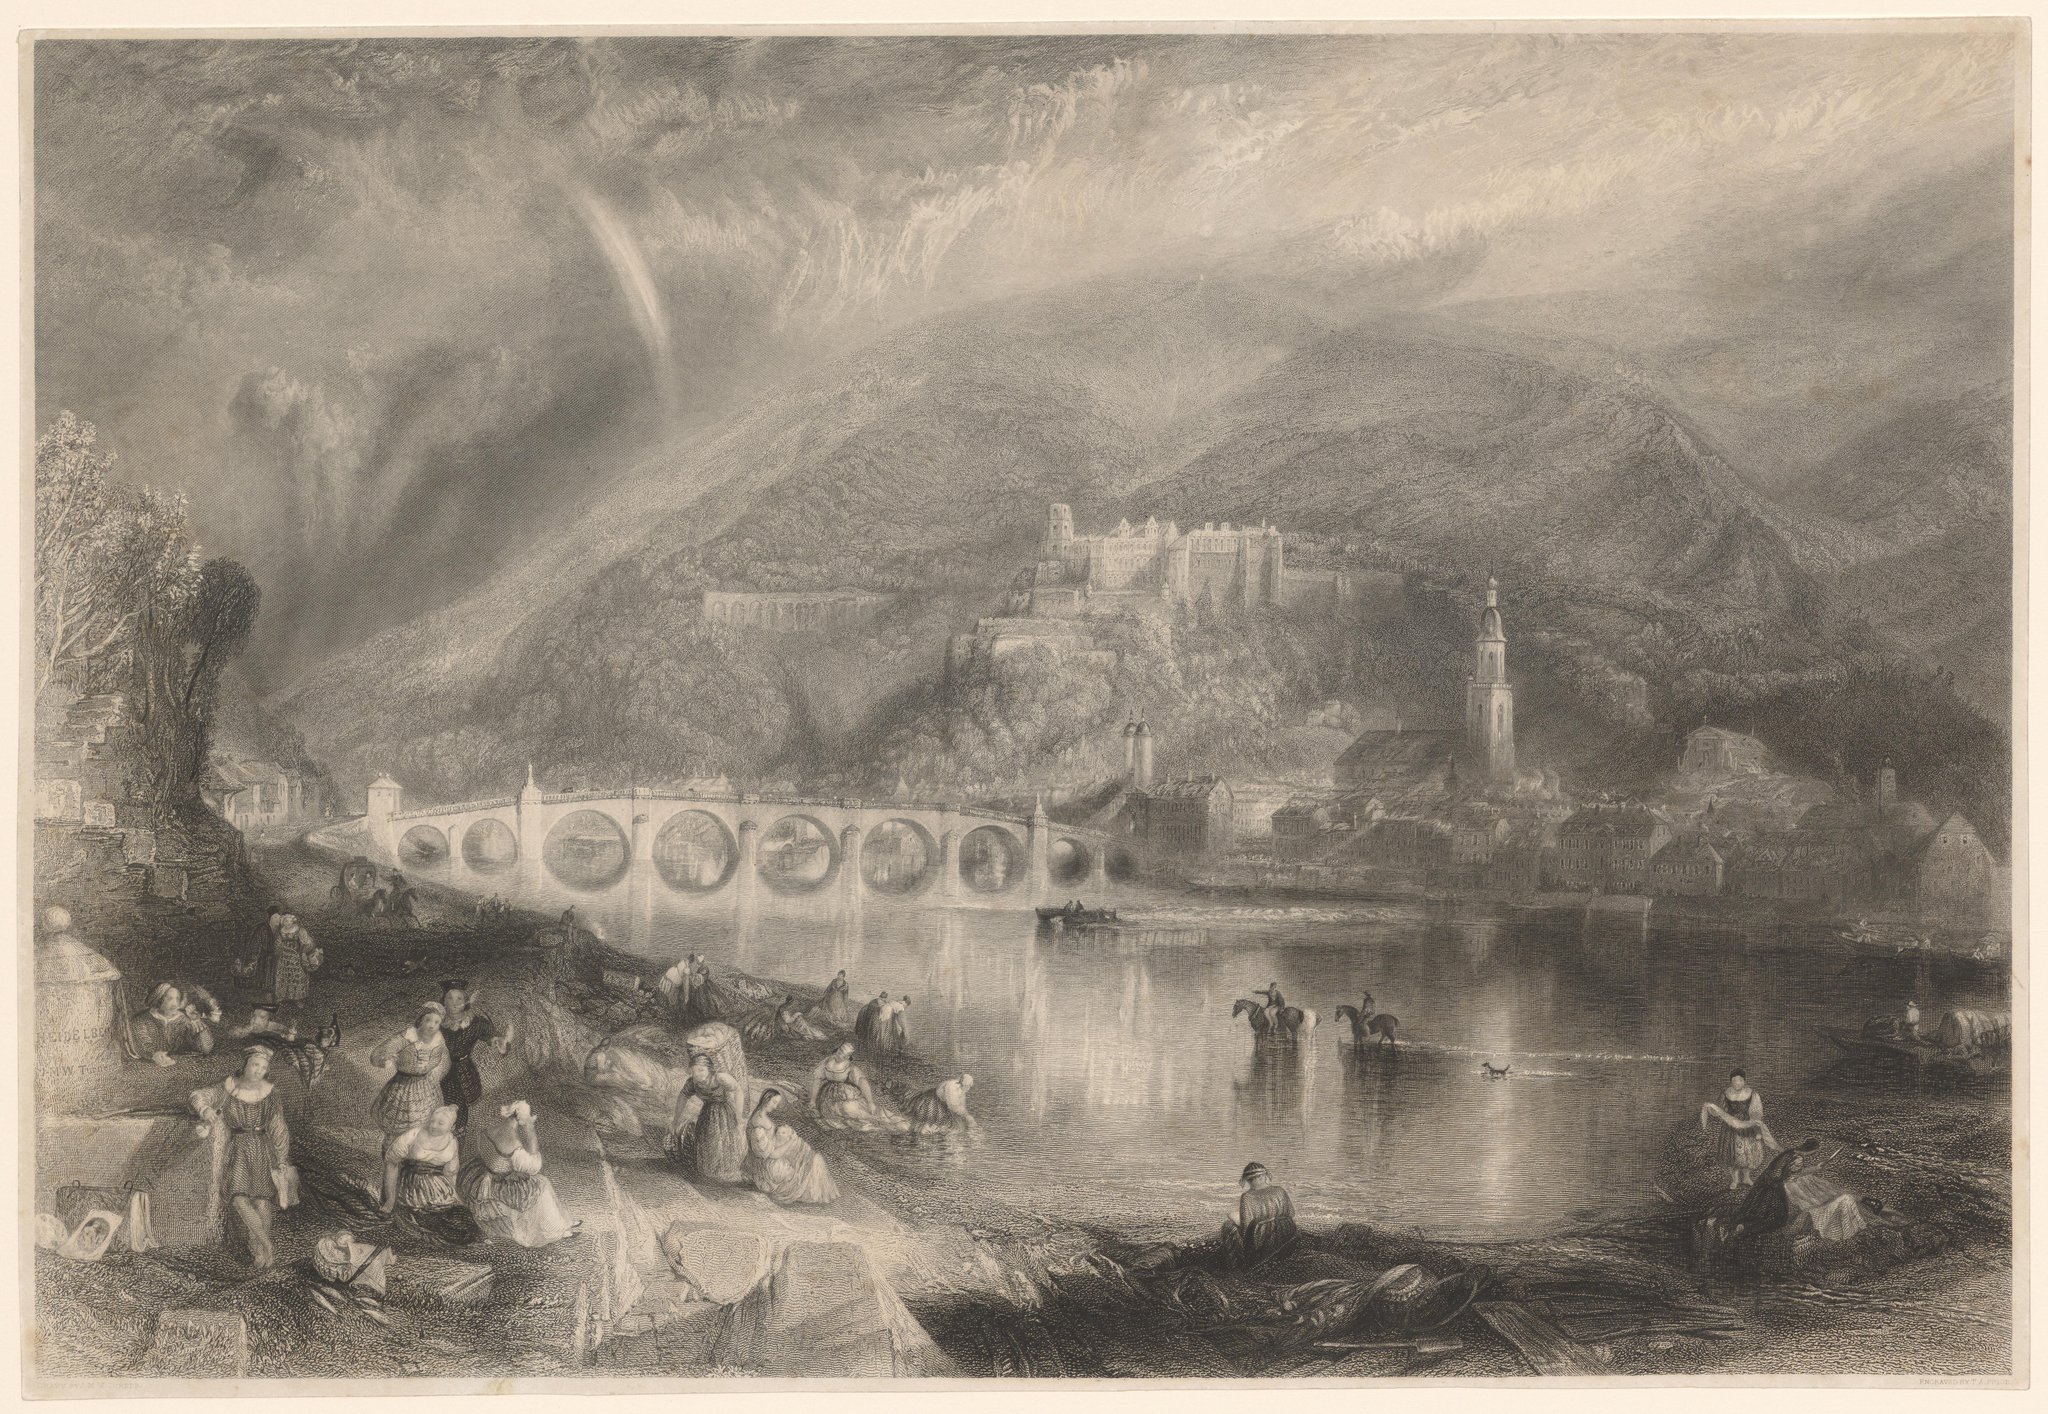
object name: print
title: Landschap met een brug over een rivier en wassende vrouwen aan de oever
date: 1819-1886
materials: paper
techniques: etching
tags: laundering, bridge, river (+ landscape with figures, staffage), dale, valley (+ landscape with figures, staffage)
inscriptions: collector's mark: Lugt 2228, collector's mark: Lugt 2228